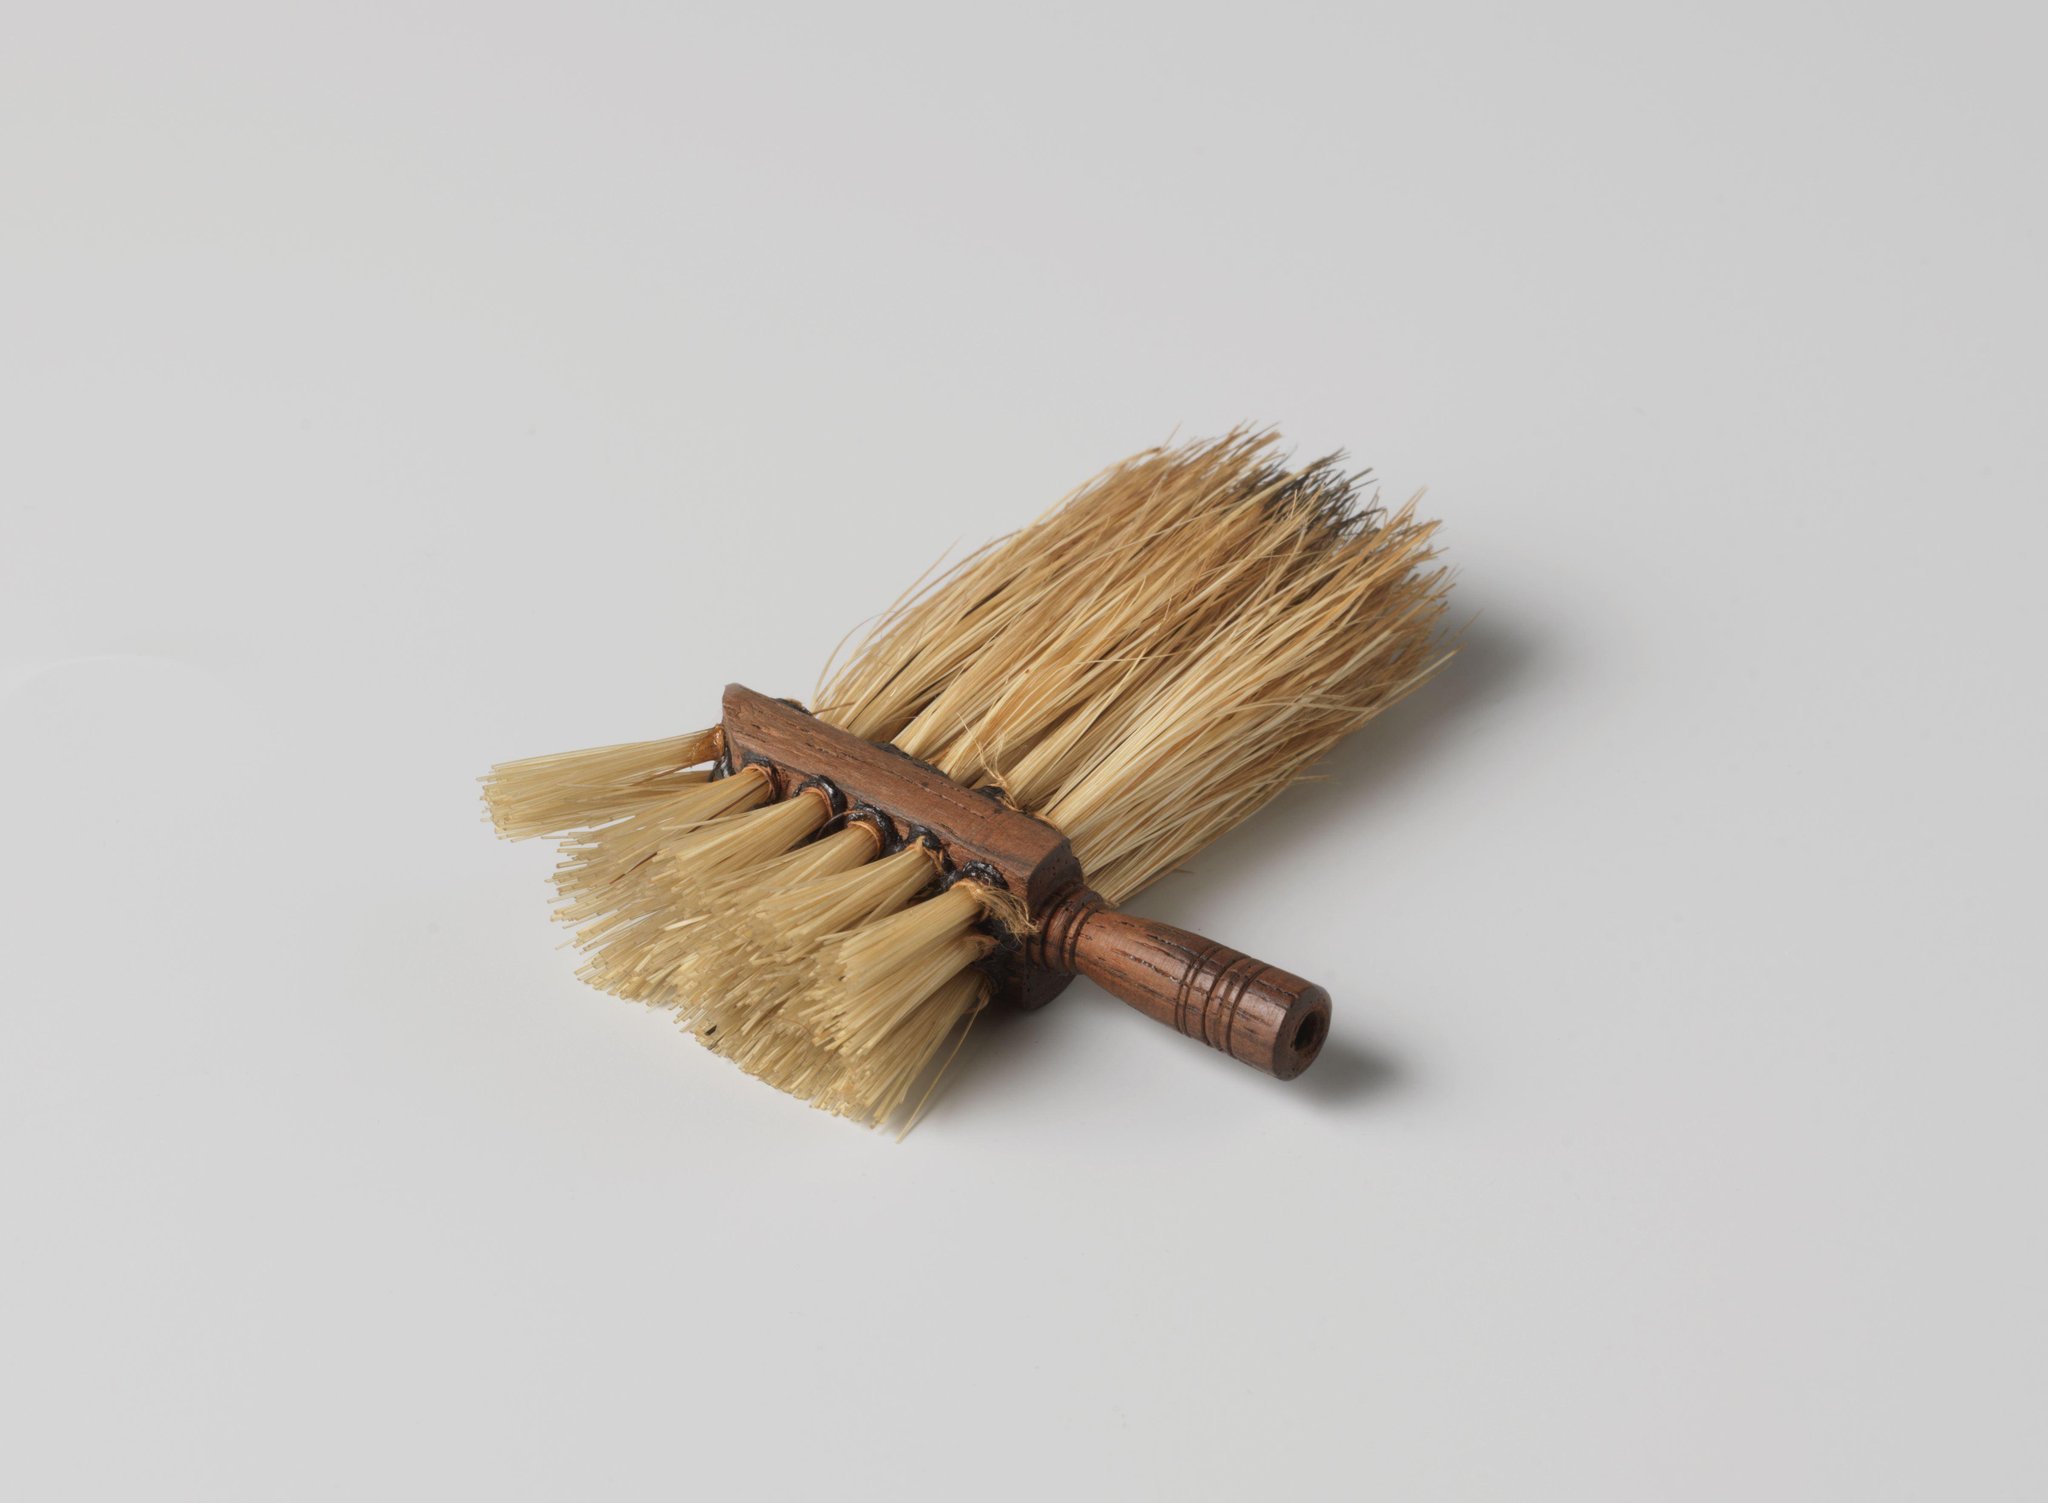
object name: whisk broom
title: Stoffer met haren aan twee zijden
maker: Anonymous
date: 1675-1699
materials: wood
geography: amsterdam